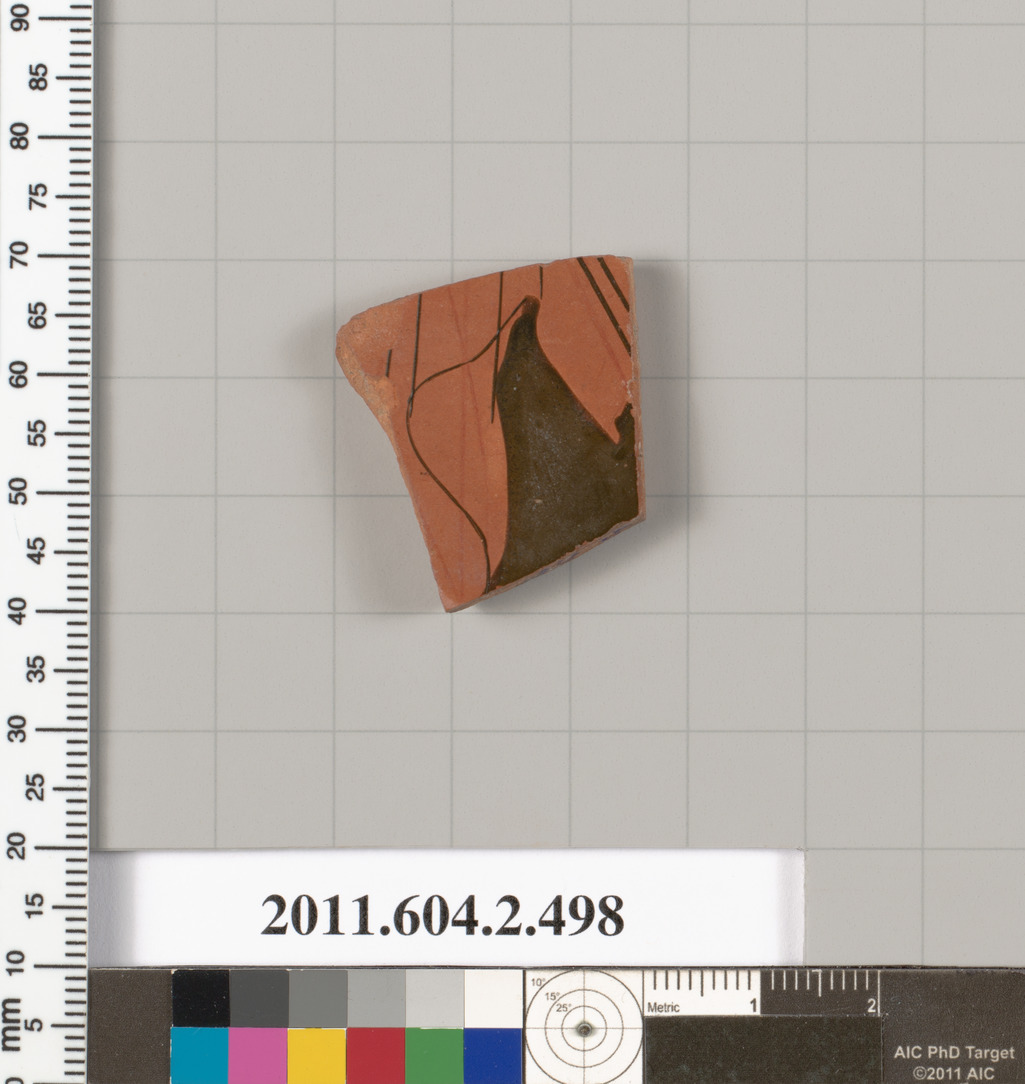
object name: column krater fragment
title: Terracotta fragment of a column-krater (bowl for mixing wine and water)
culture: greek, attic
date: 460-440 BCE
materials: terracotta